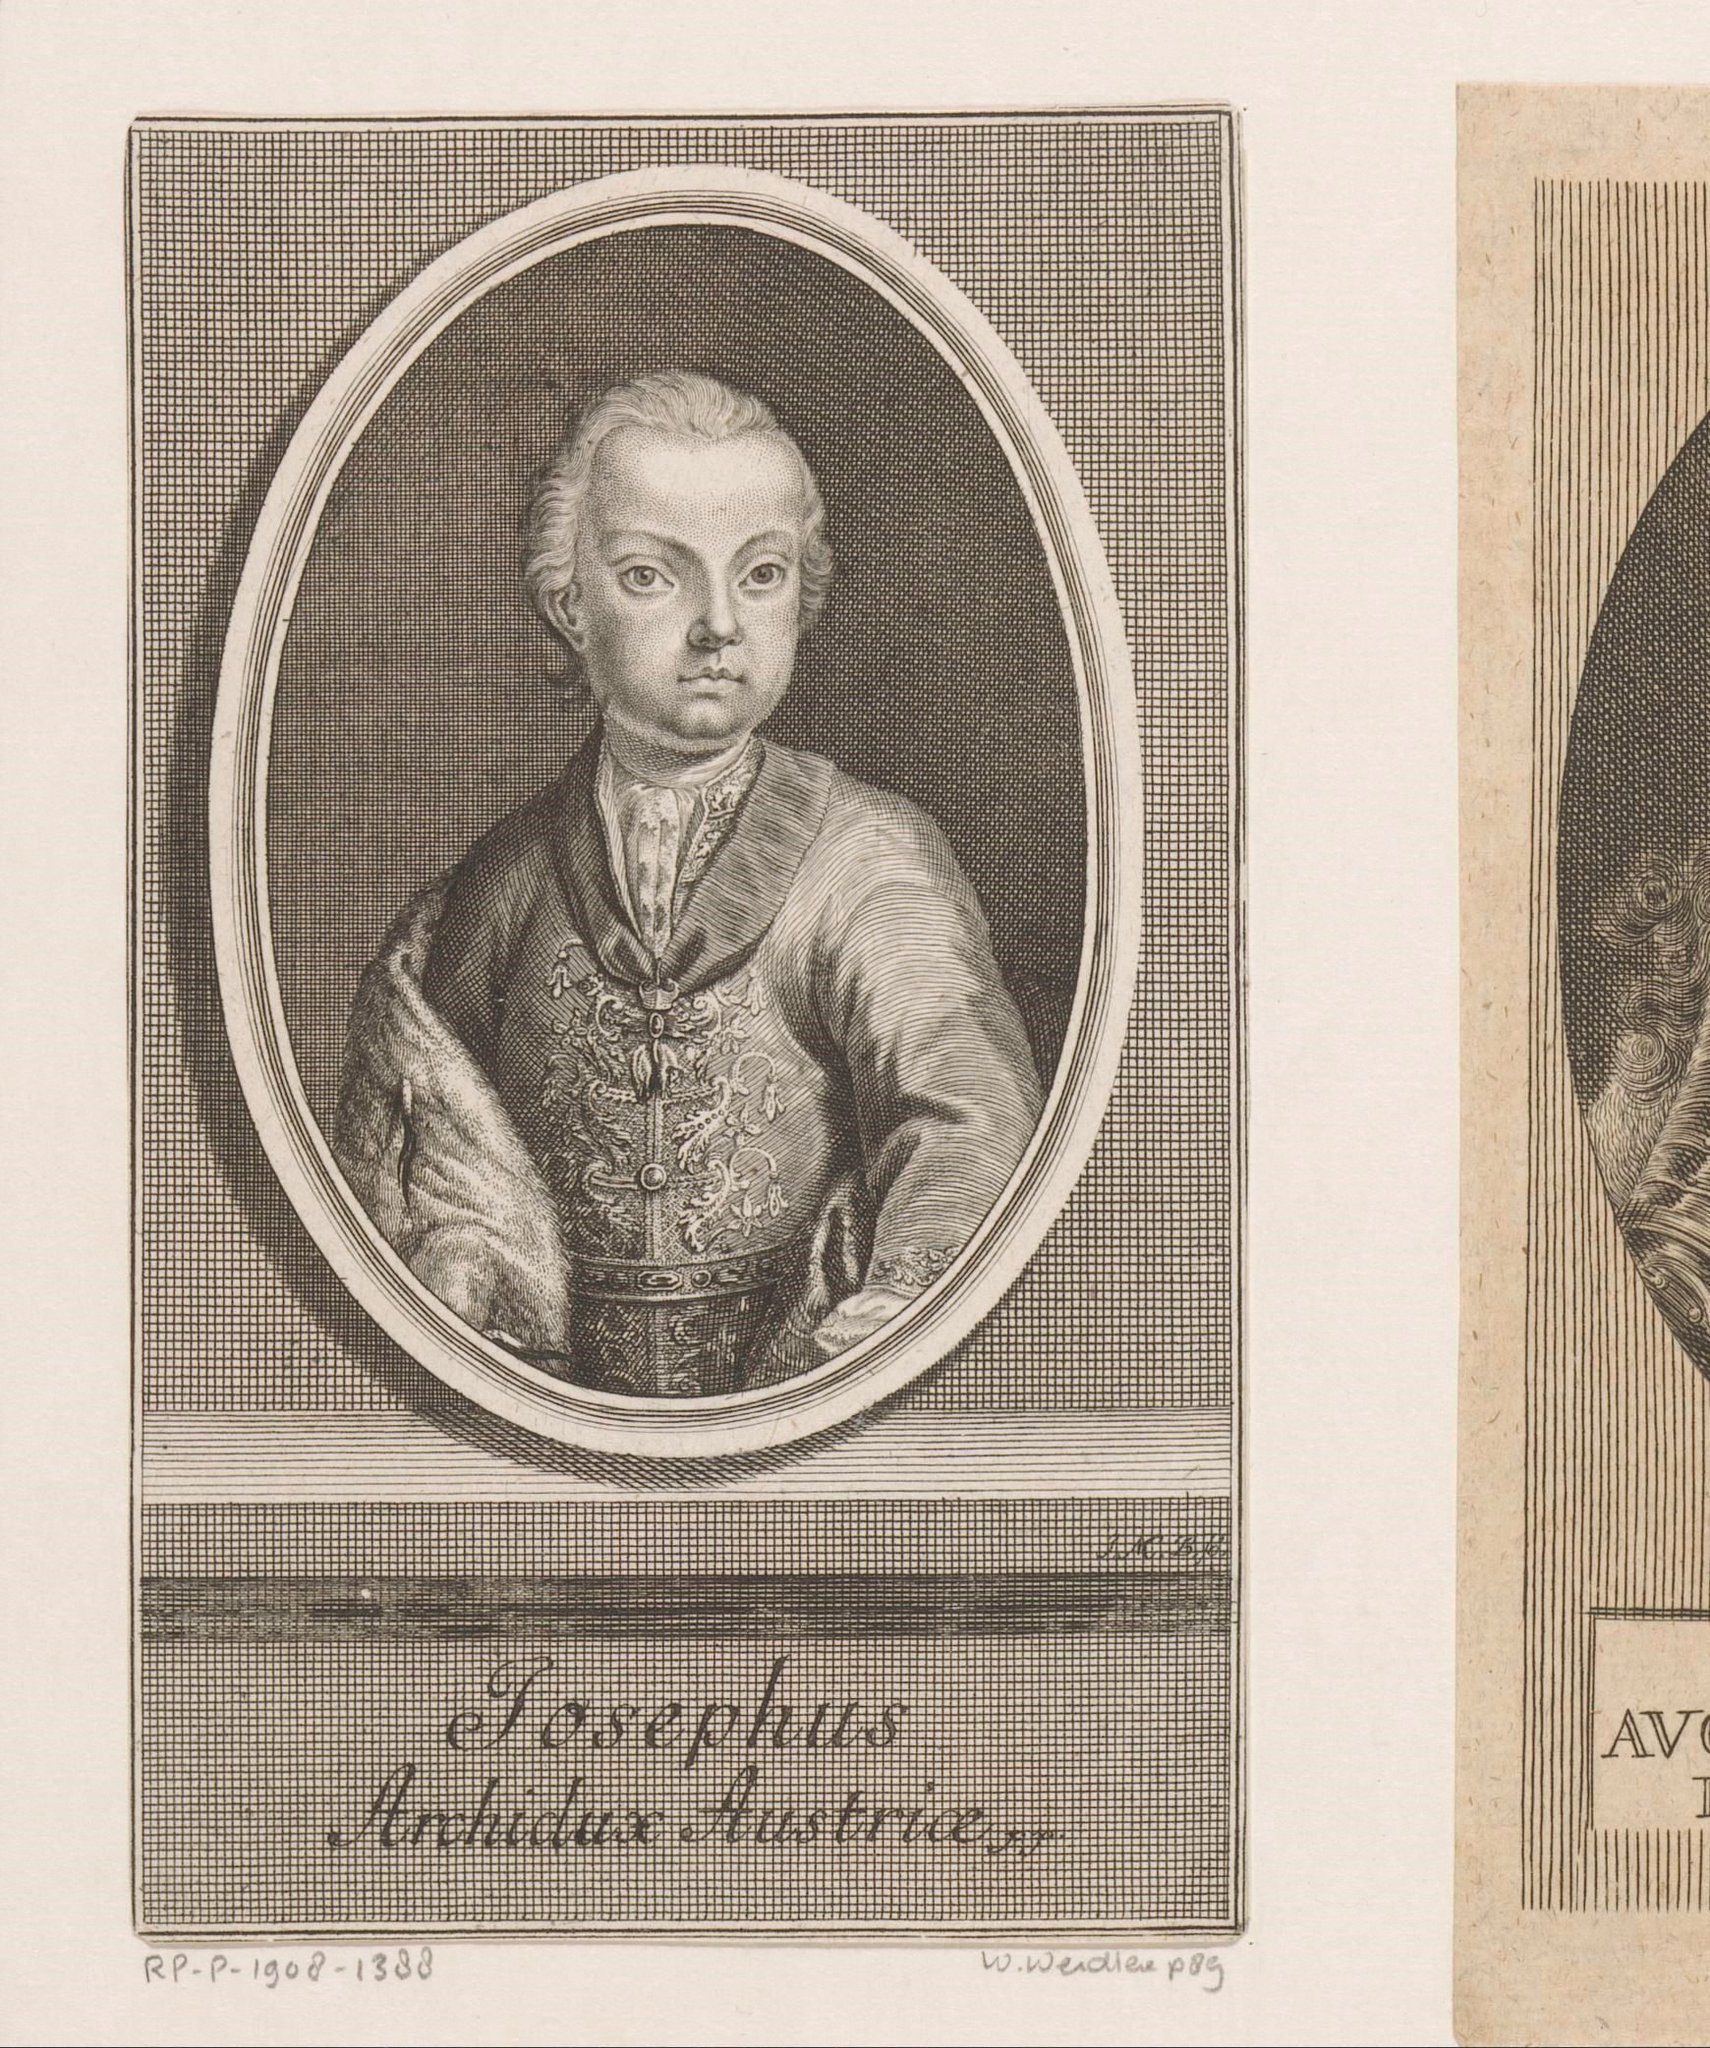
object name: print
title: Portret van Rooms-Duits keizer Jozef II als aartshertog van Oostenrijk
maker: johann martin bernigeroth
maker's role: print maker, publisher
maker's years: 1713-1767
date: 1751-1764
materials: paper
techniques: engraving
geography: leipzig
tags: vienna, jozef ii (duits keizer), historical persons, knighthood order of the golden fleece - insignia of a knighthood order, e.g.: badge, chain (with name of order)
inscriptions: collector's mark: Lugt 2228